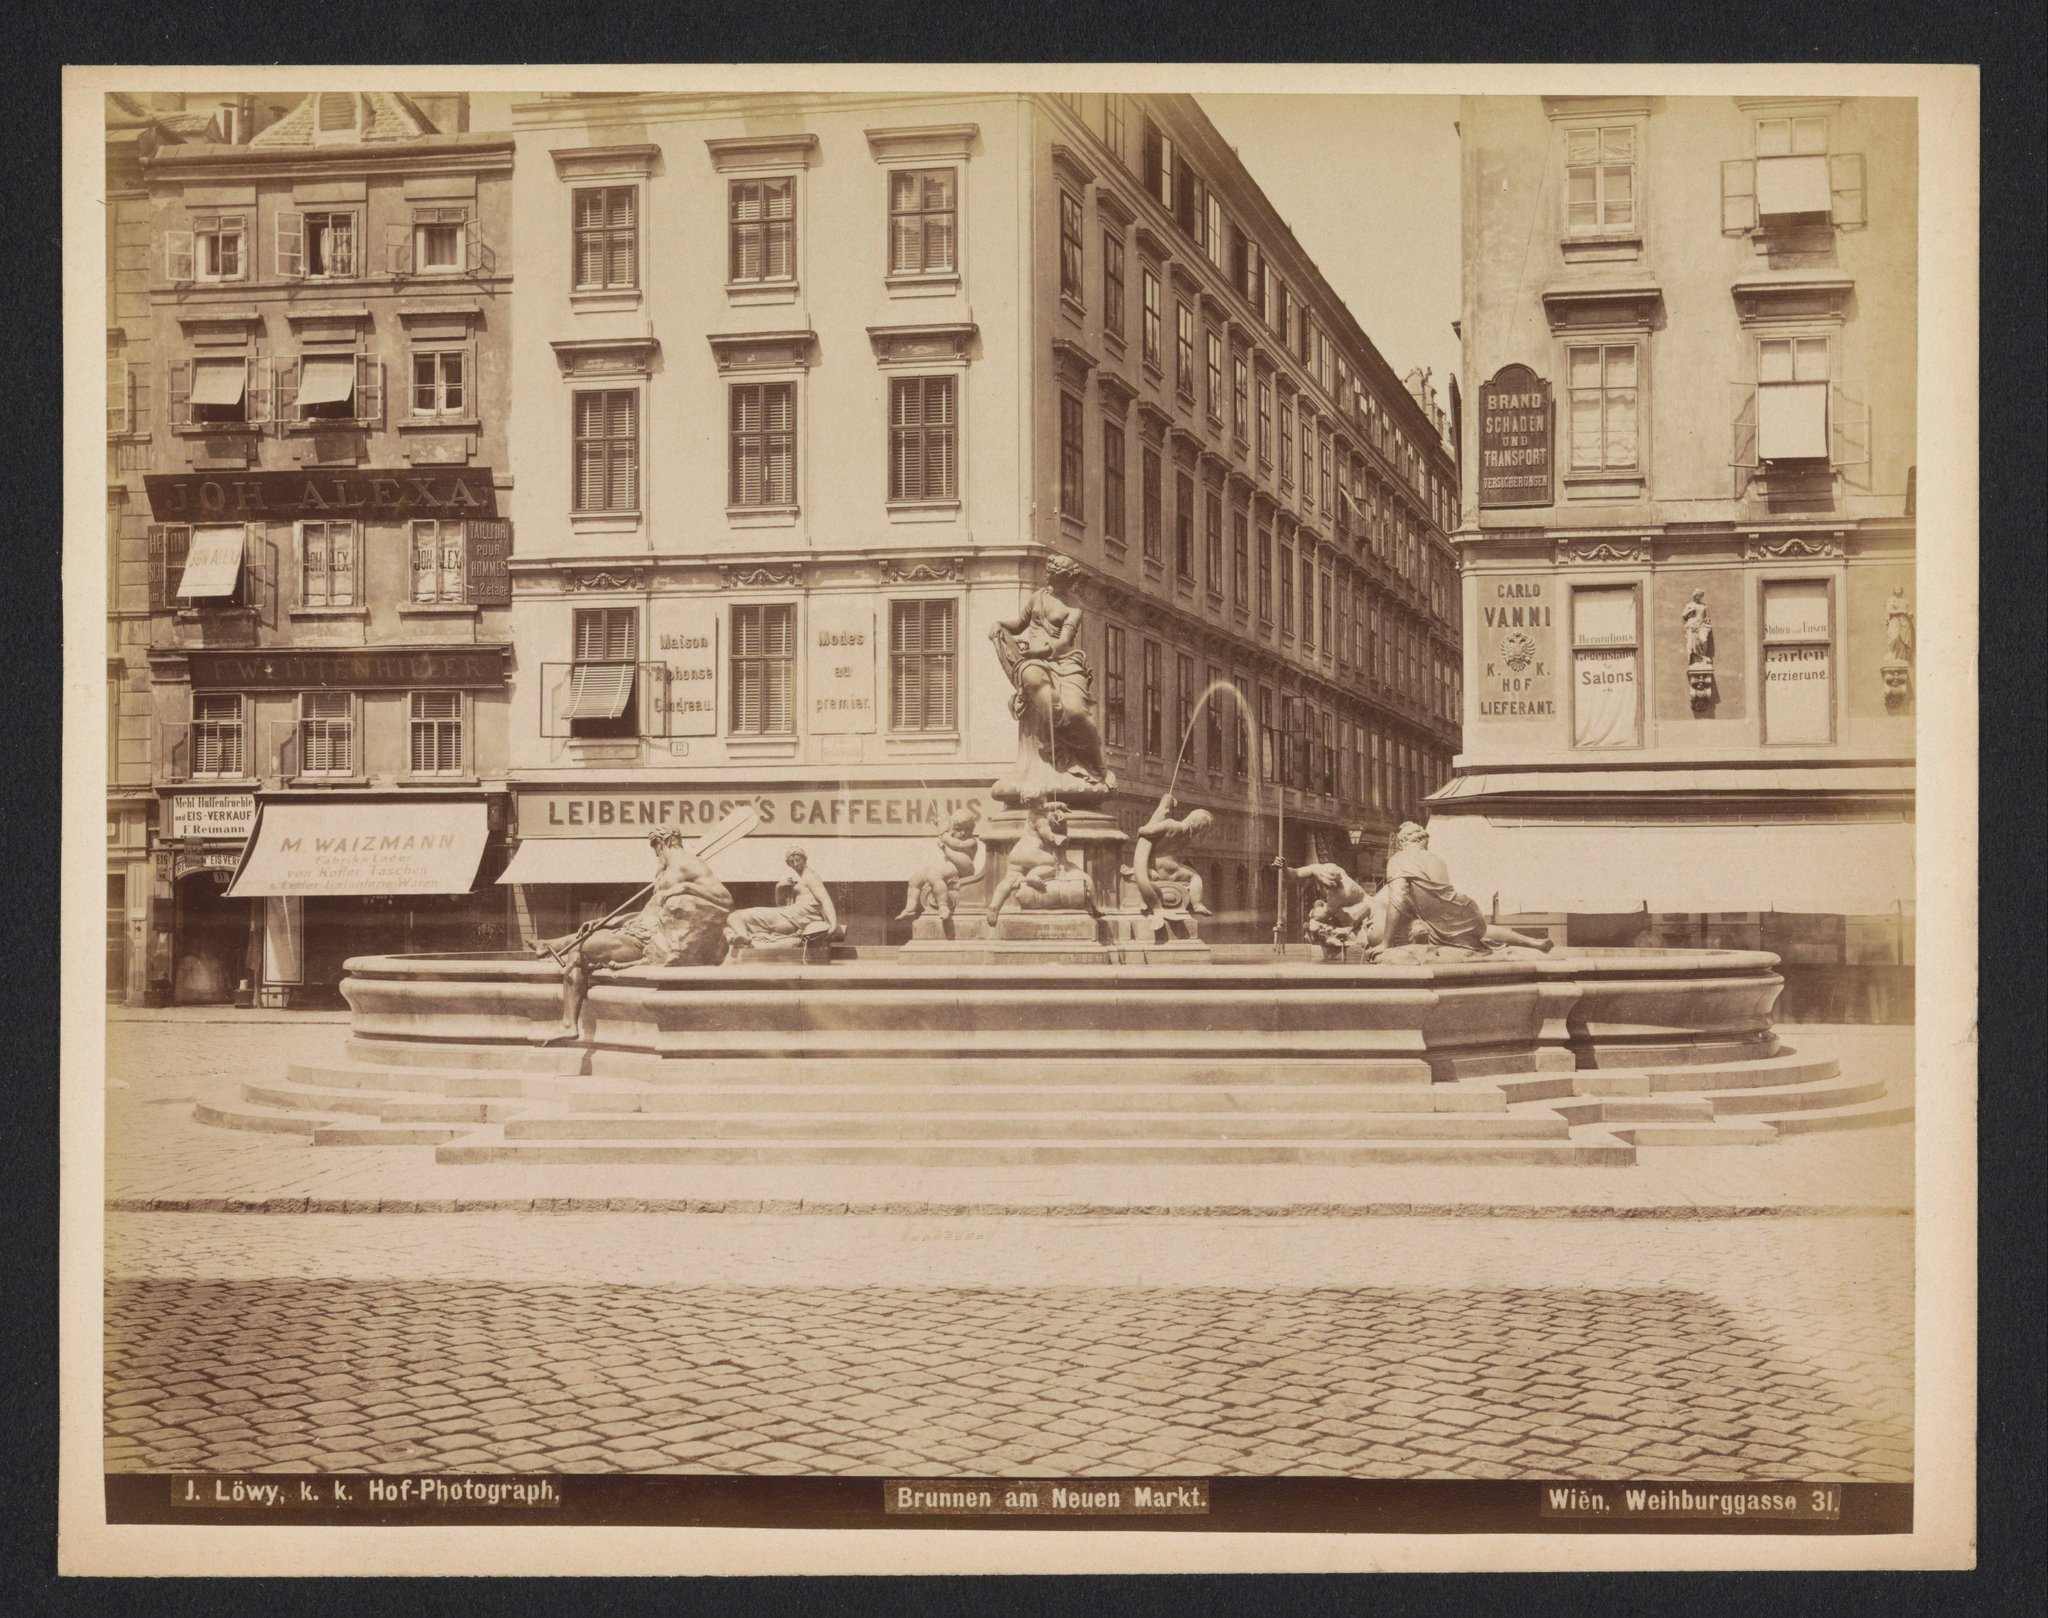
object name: photograph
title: Providentiafontein op de Neuer Markt te Wenen, Oostenrijk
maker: josef löwy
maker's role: publisher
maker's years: 1835-1902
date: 1860-1875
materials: cardboard, paper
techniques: albumen print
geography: vienna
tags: urban housing, ornamental fountain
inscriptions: address: ‘Wien. Weihburggasse 31.’